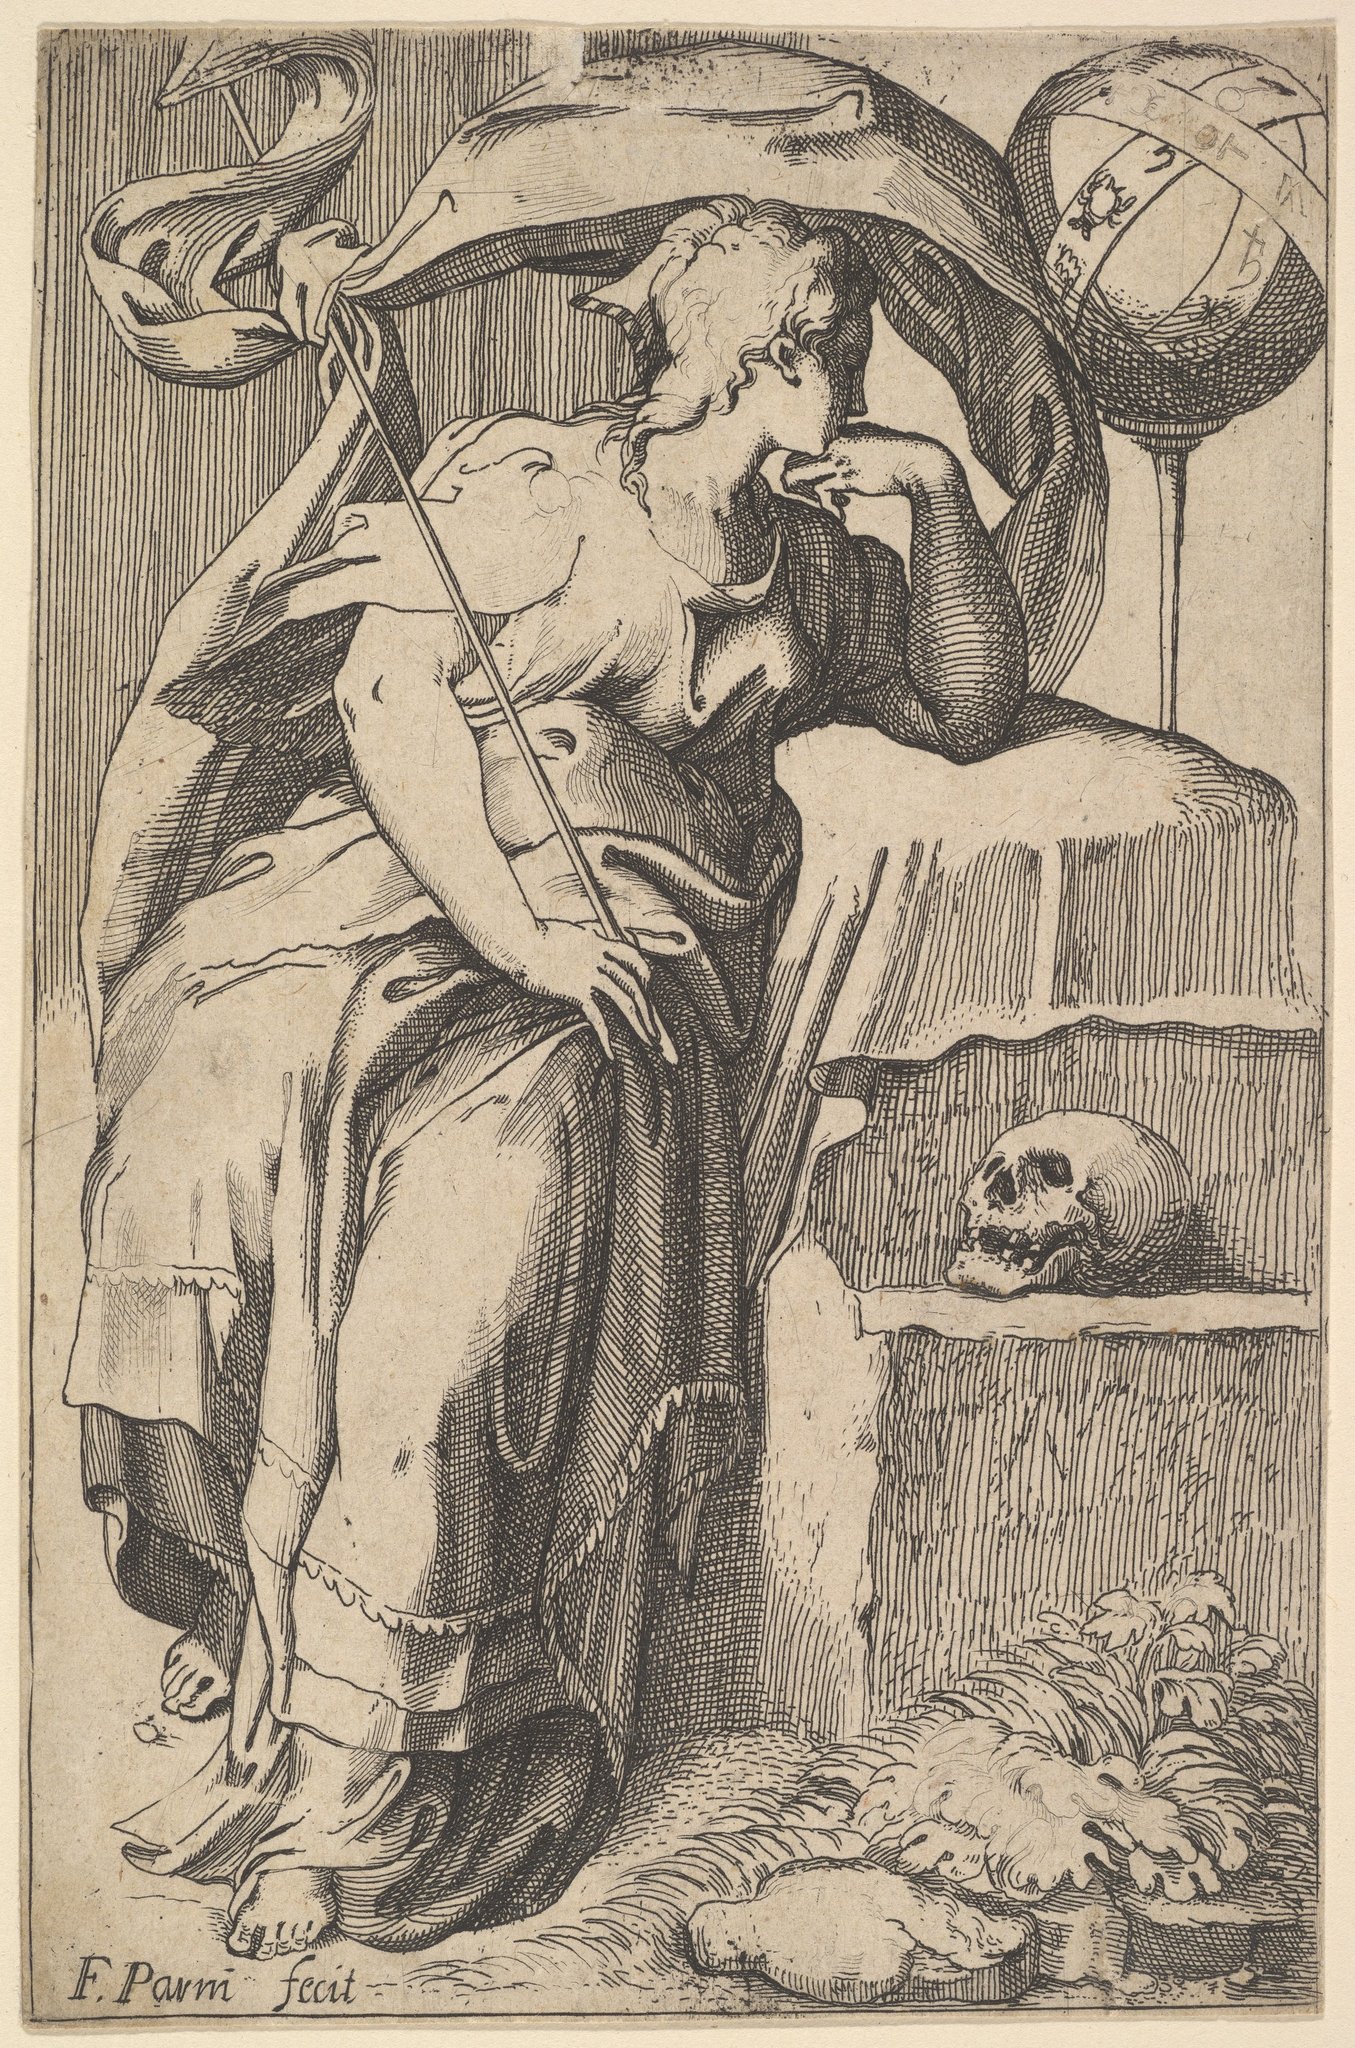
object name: print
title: Astrology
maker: anonymous, italian, 17th century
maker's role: artist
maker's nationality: italian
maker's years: 1600-1700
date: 1601-1700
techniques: etching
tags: skulls,women,astrology